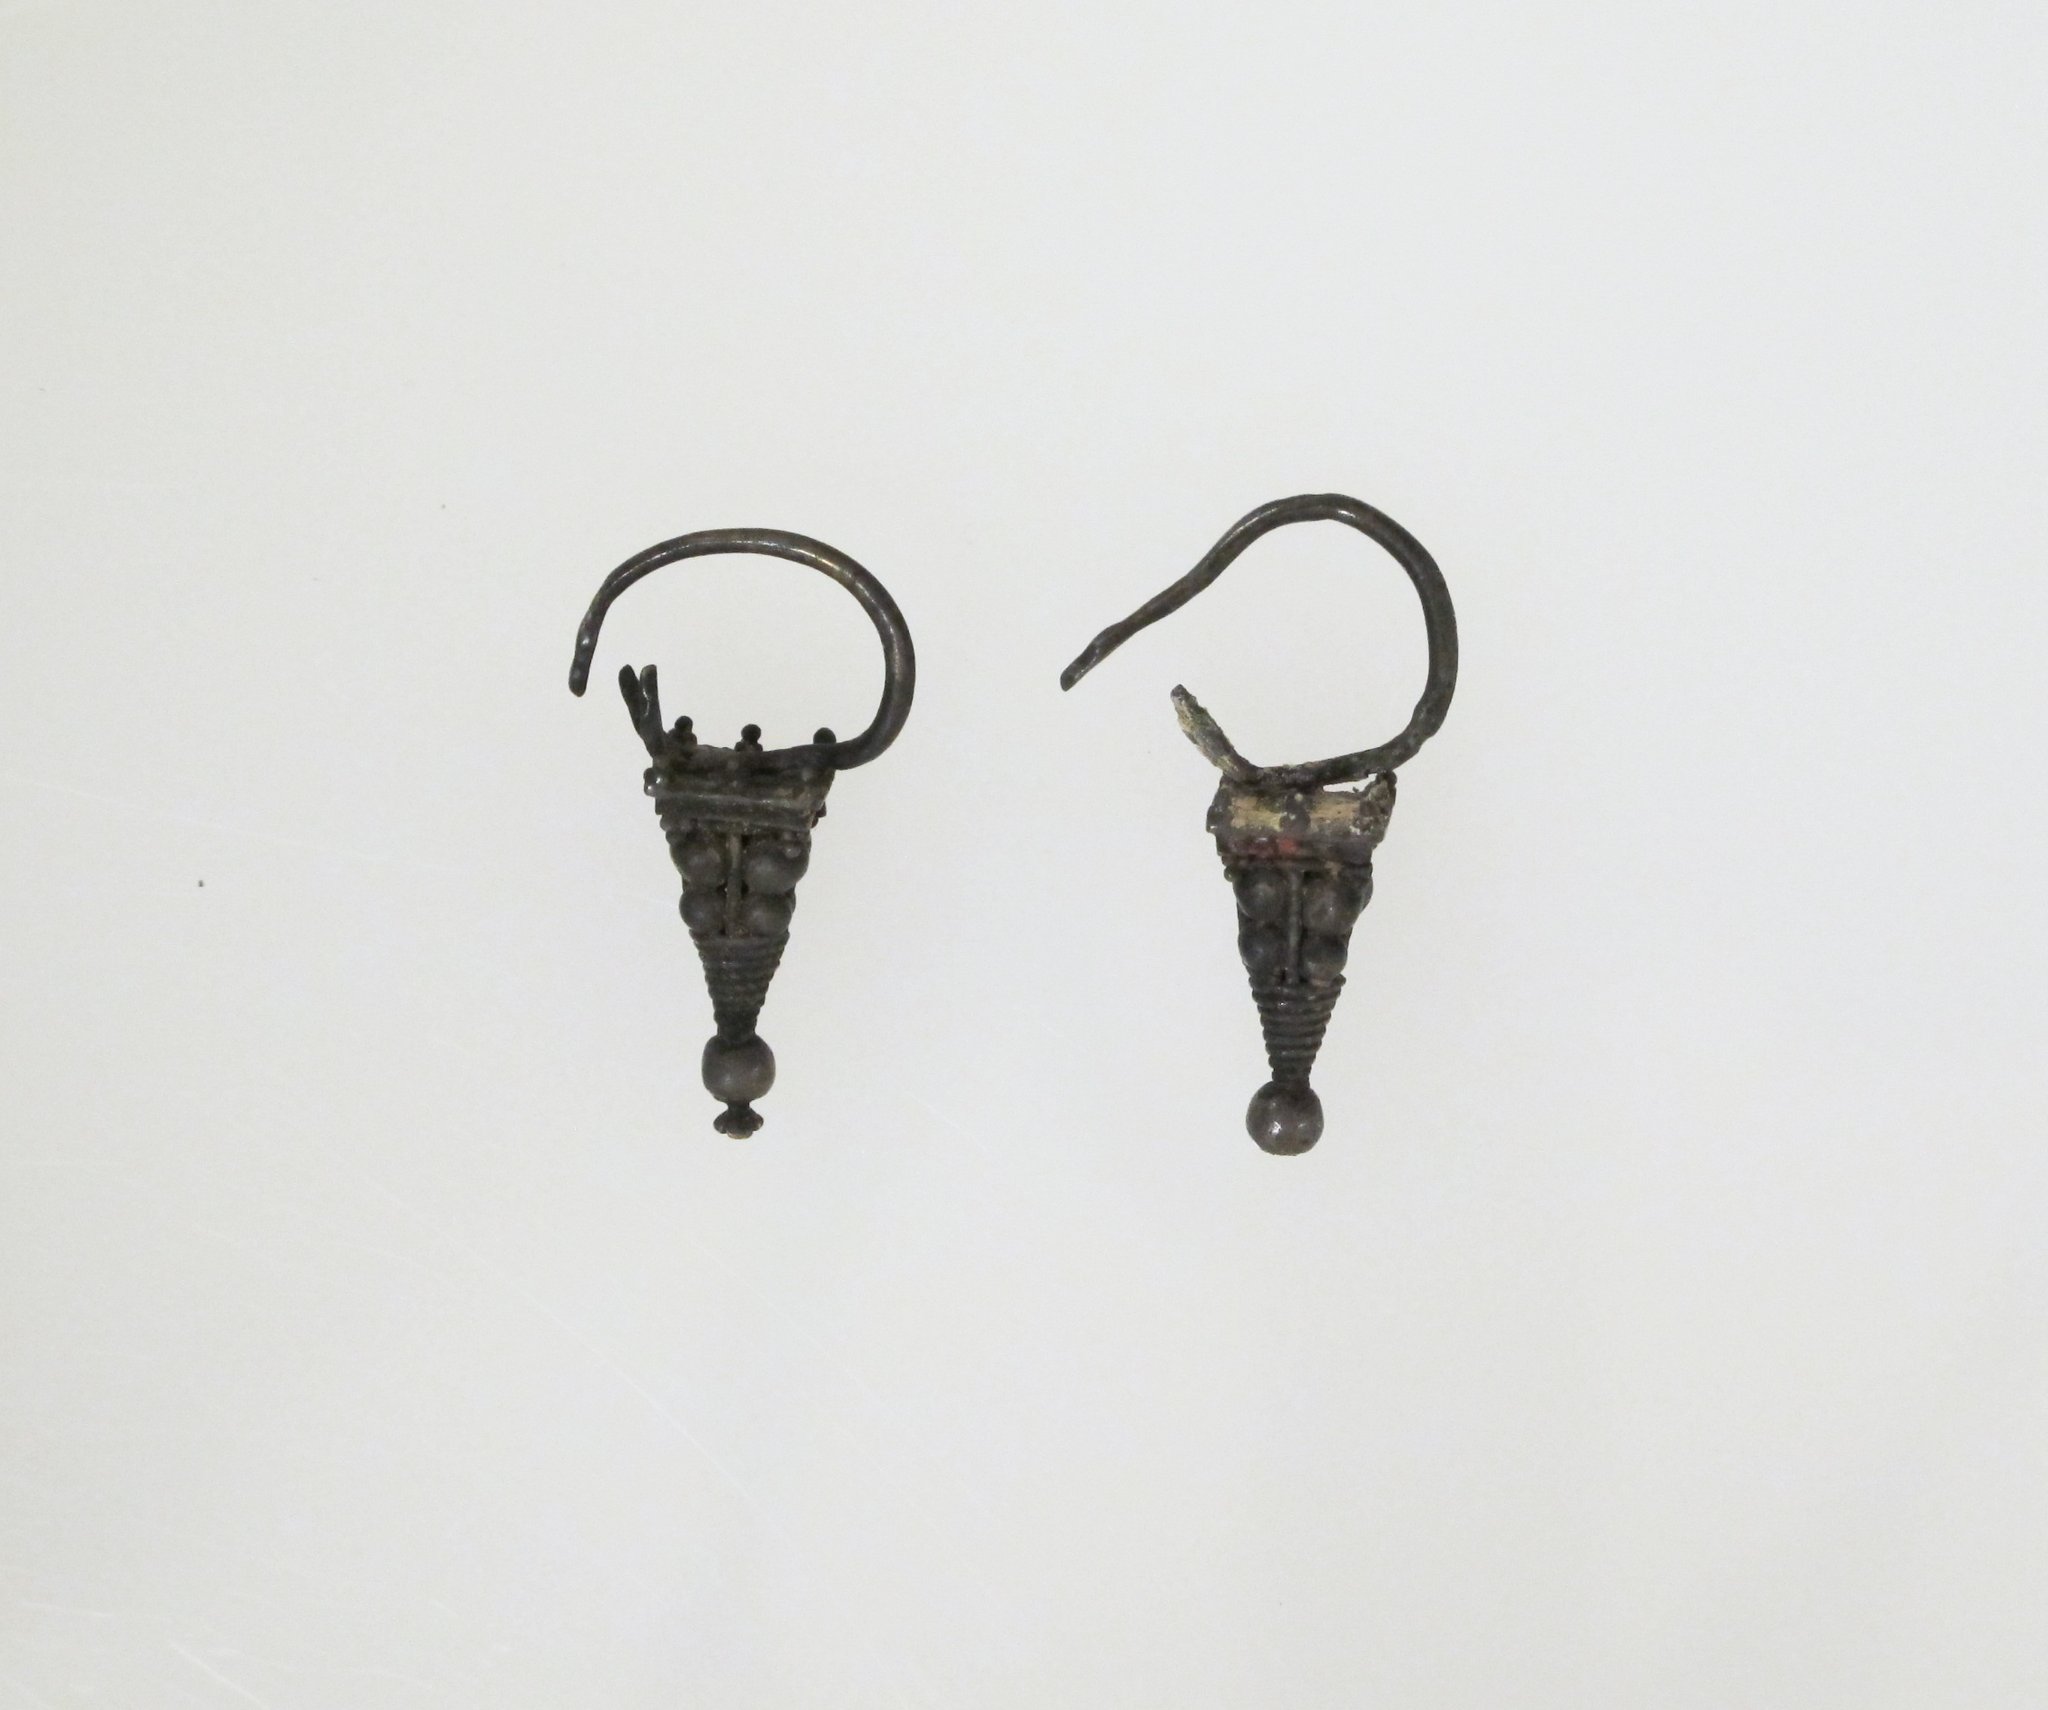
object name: earring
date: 500-301 BCE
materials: silver